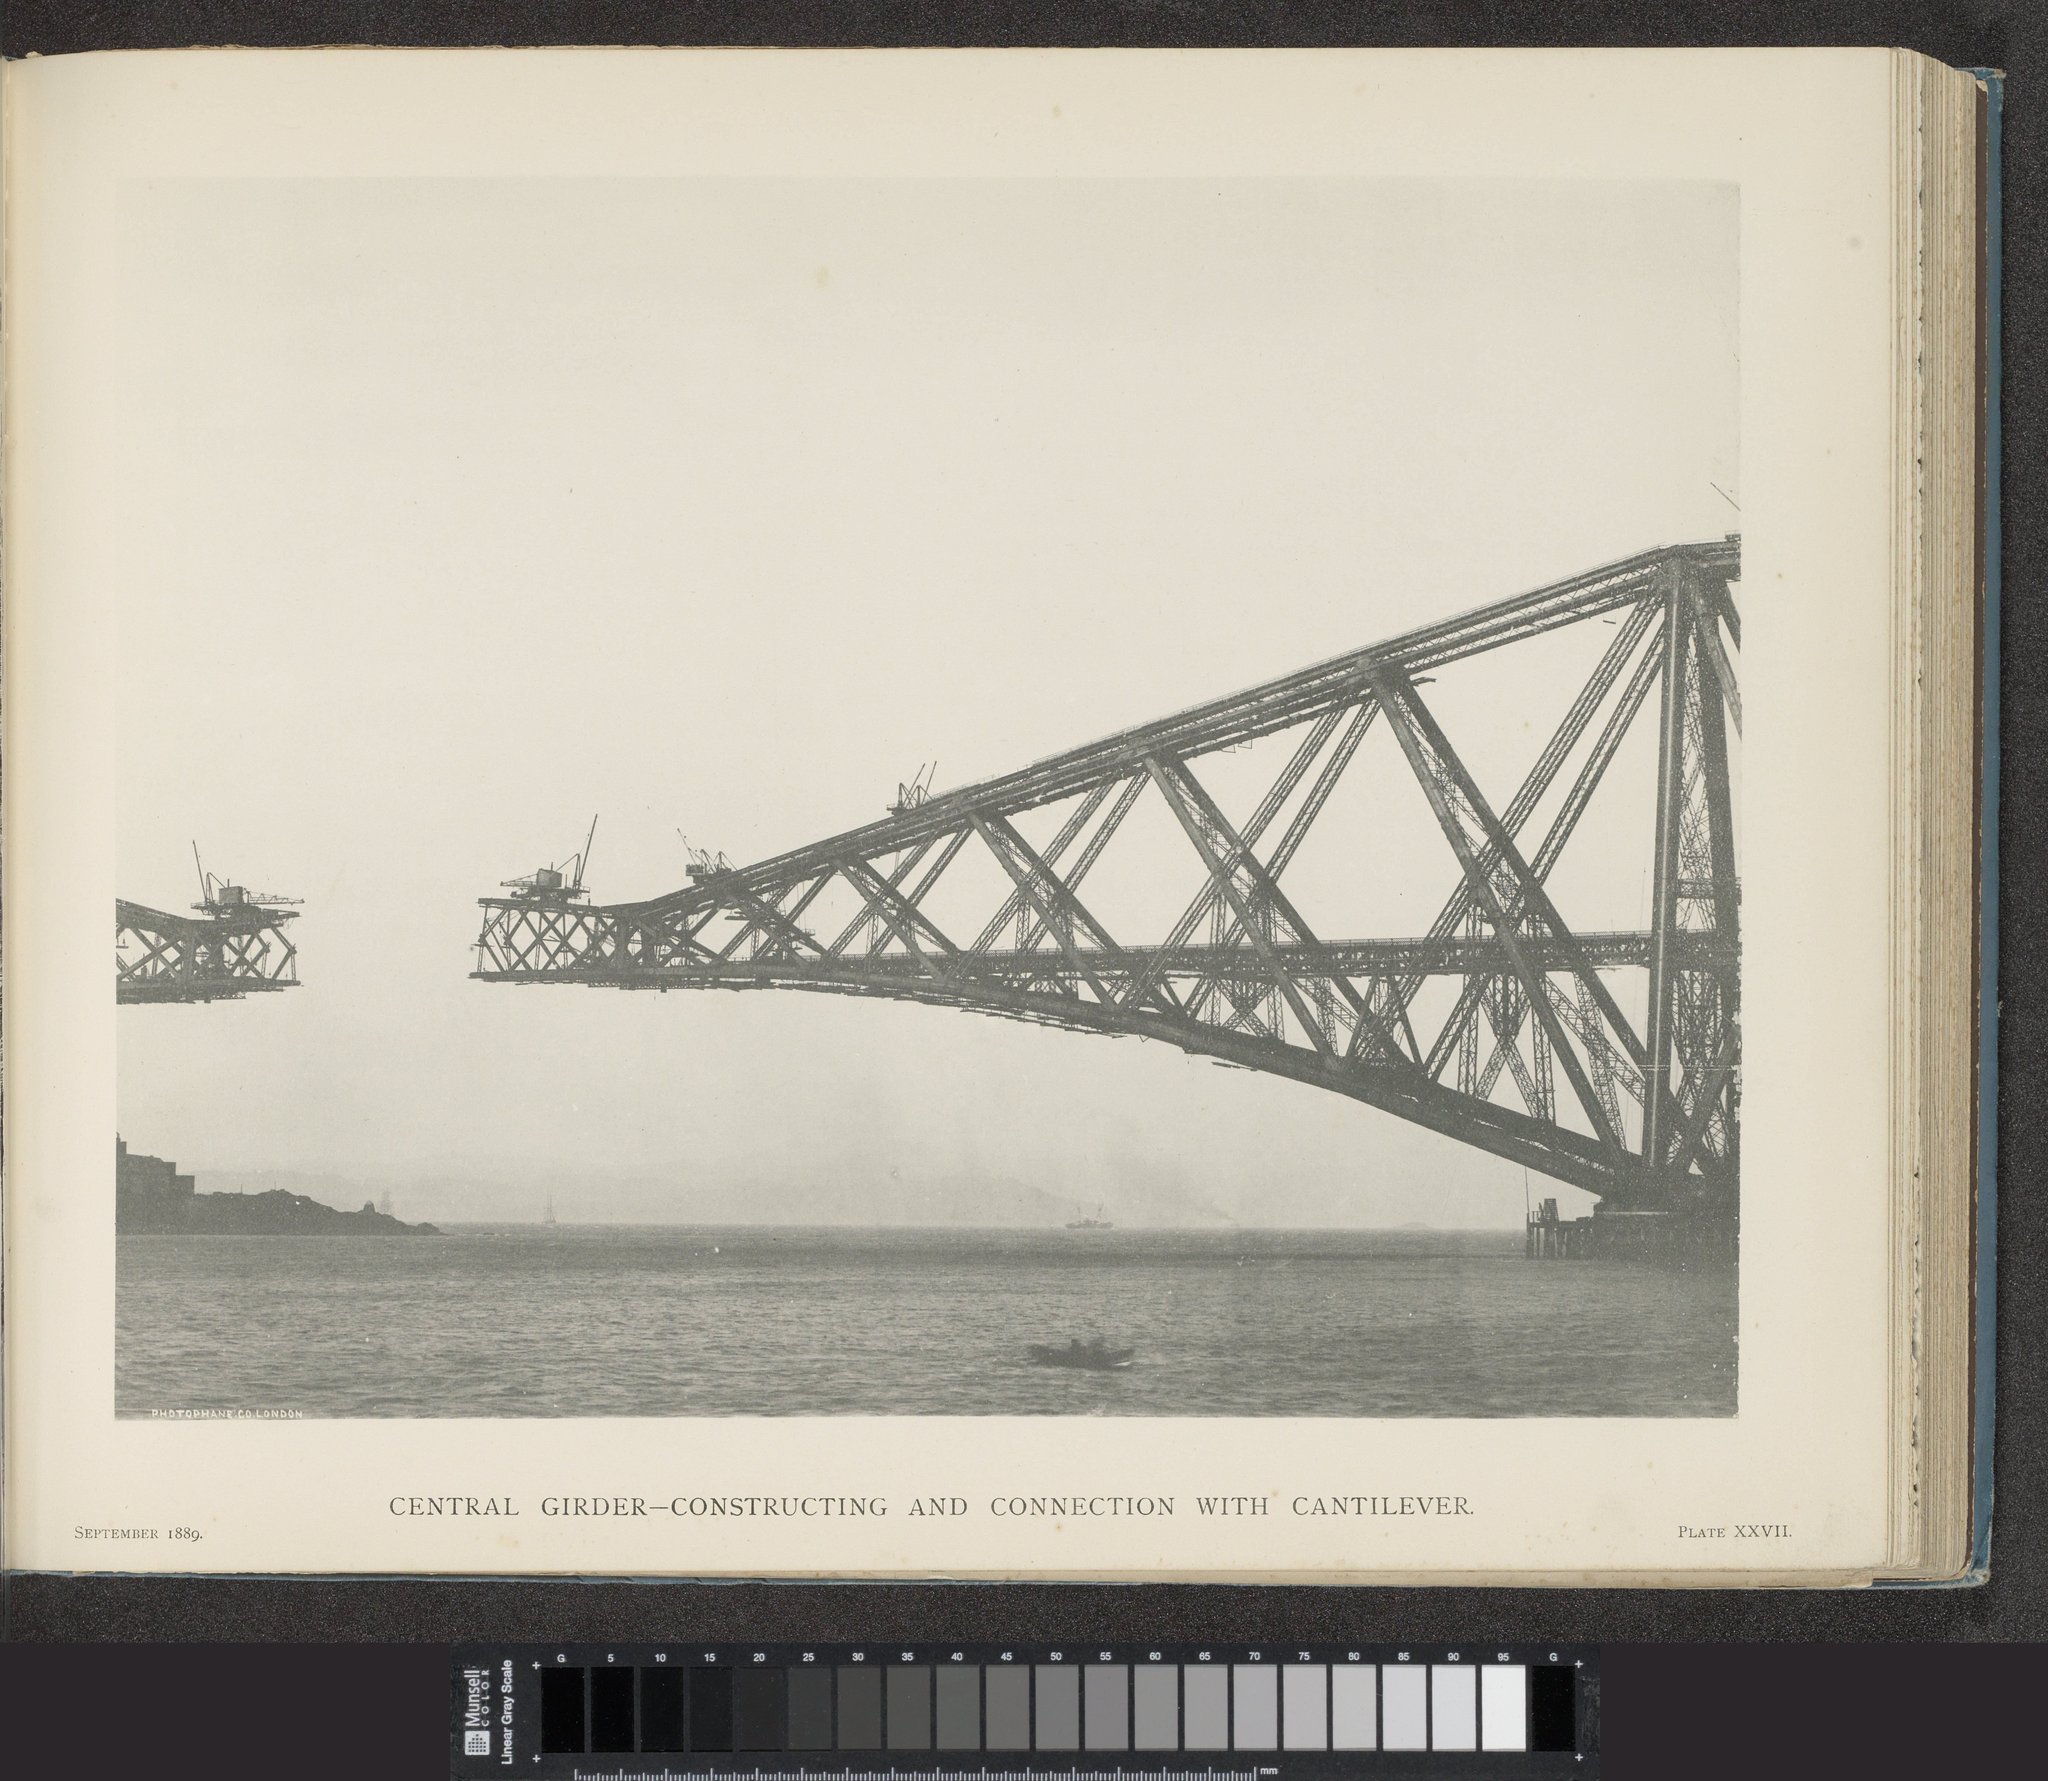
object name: photomechanical print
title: Central girder-constructing and connection with cantilever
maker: Anonymous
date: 1809-1889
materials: paper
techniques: photograph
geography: london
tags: building materials, landscape with bridge, viaduct or aqueduct, bridge, building-site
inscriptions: number: ‘Plate XXVII.’